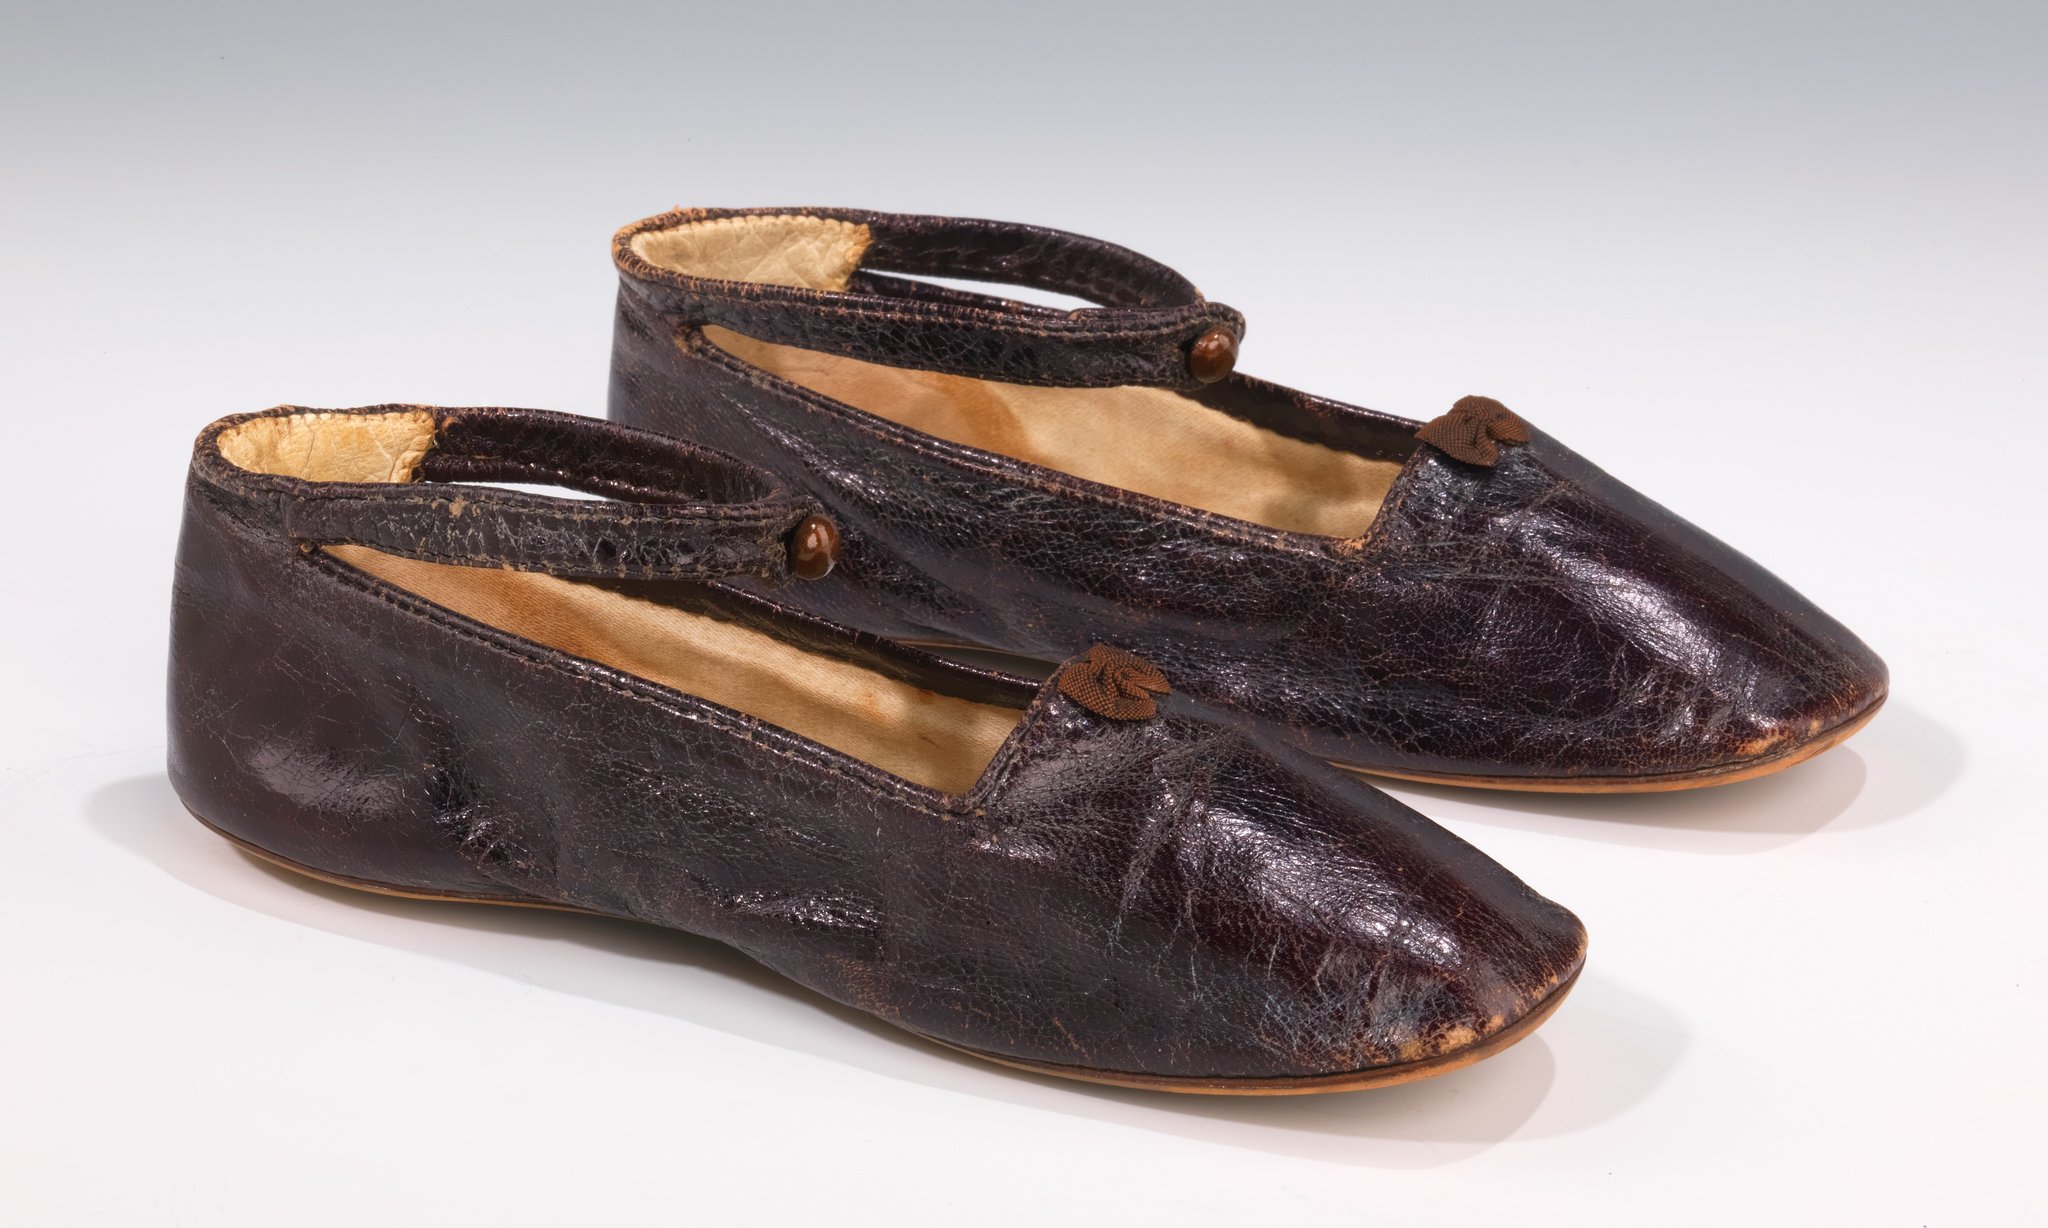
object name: shoe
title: Shoes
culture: european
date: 1850-1869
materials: leather